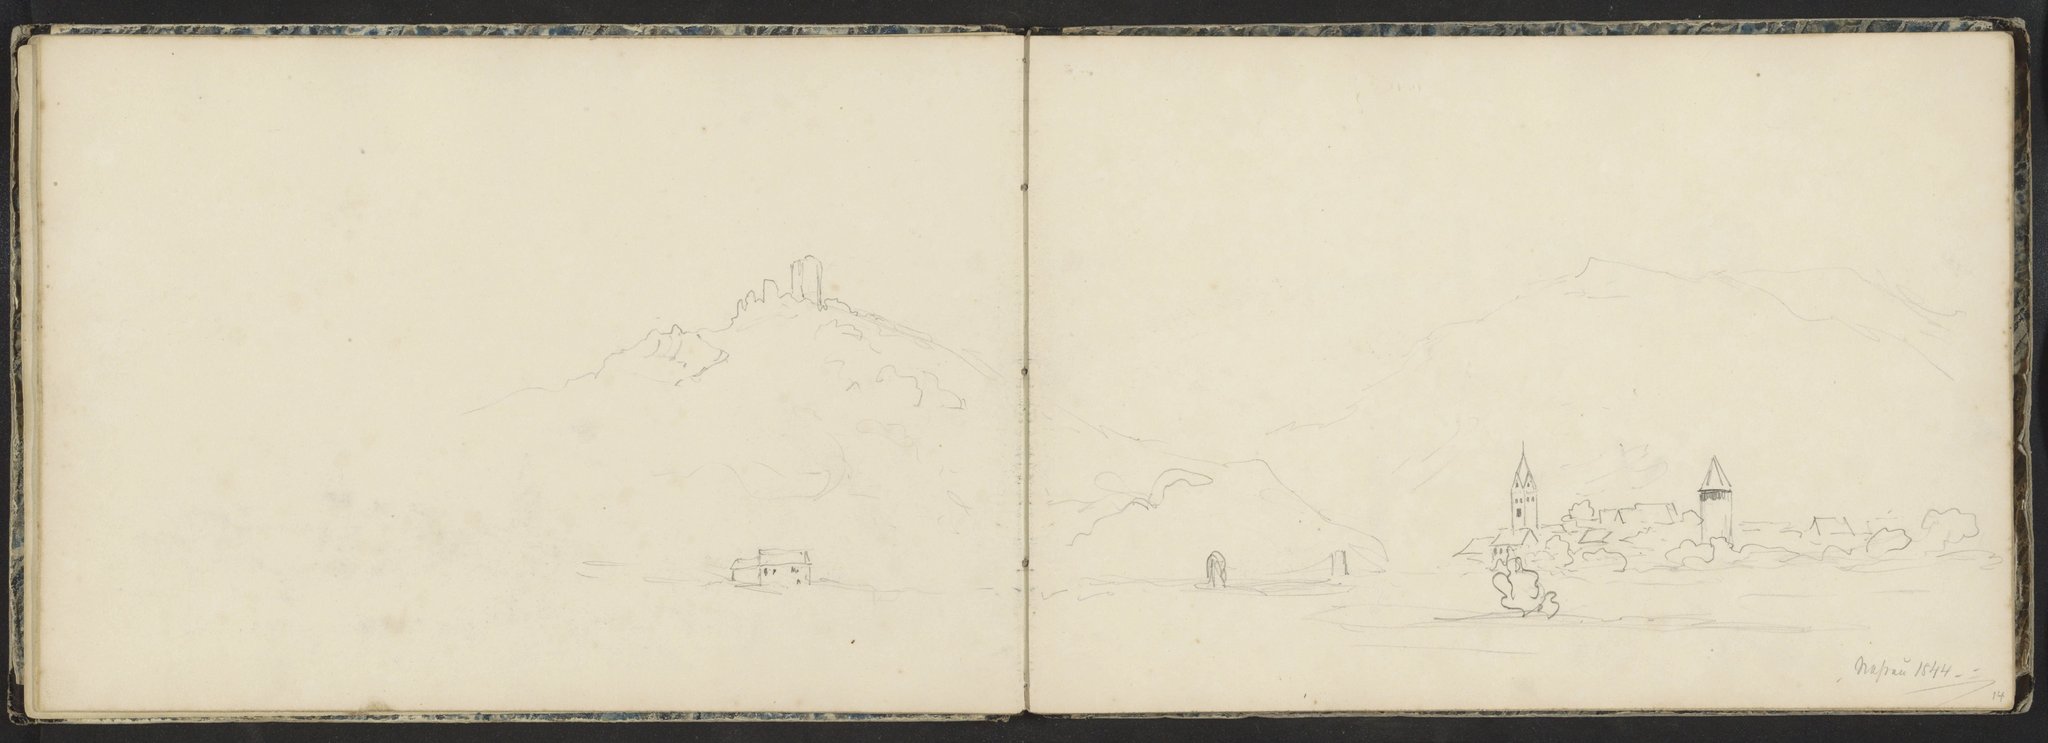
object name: sketchbook leaf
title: Gezicht op Nassau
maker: johannes tavenraat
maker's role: draughtsman, painter, print maker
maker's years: 1809-1881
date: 1844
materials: paper, pencil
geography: nassau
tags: city-view, and landscape with man-made constructions, landscapes with waters, waterscapes, seascapes (in the temperate zone)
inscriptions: date and inscription: ‘Nassau 1844.-’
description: Blad 13 verso en 14 recto uit een schetsboek met 44 bladen.